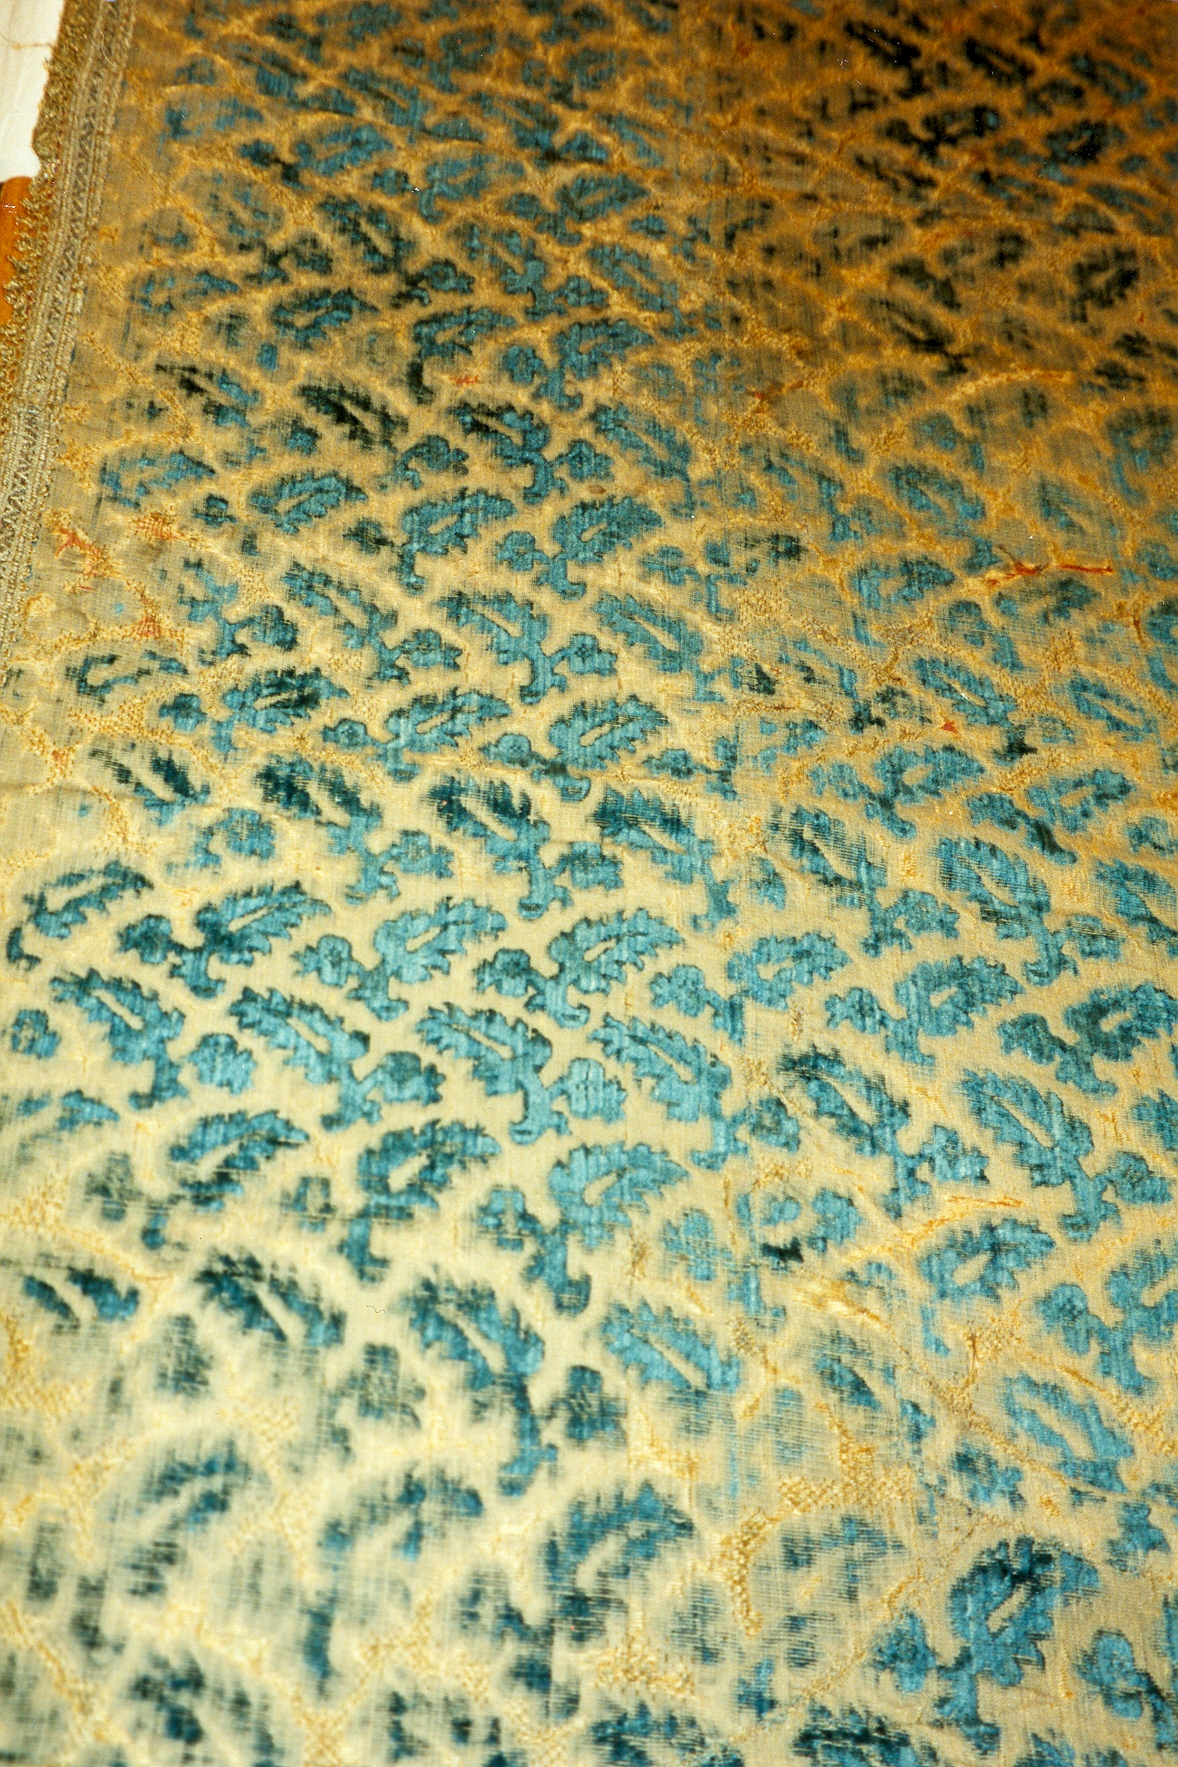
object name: textile cover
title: Cover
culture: italian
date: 1601-1700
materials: metal, silk